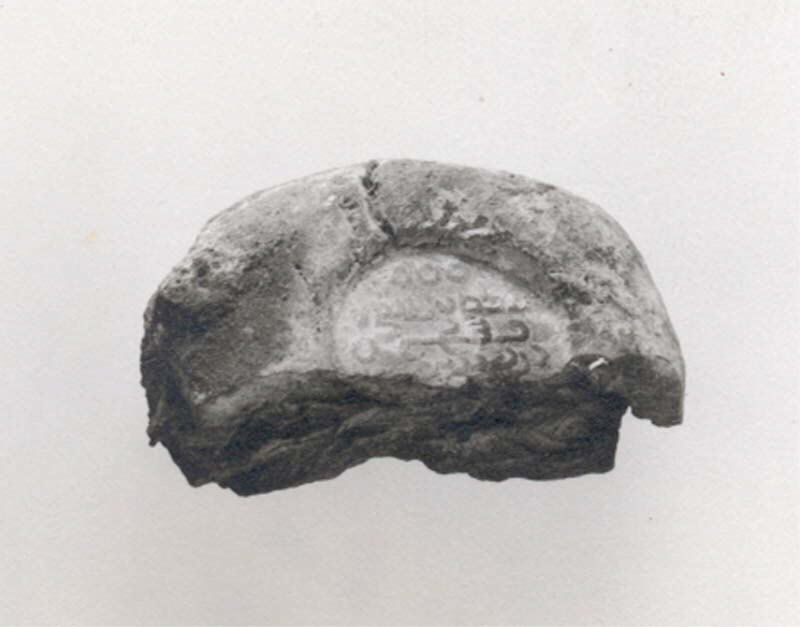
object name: sealing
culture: sasanian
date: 601-700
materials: clay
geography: iran